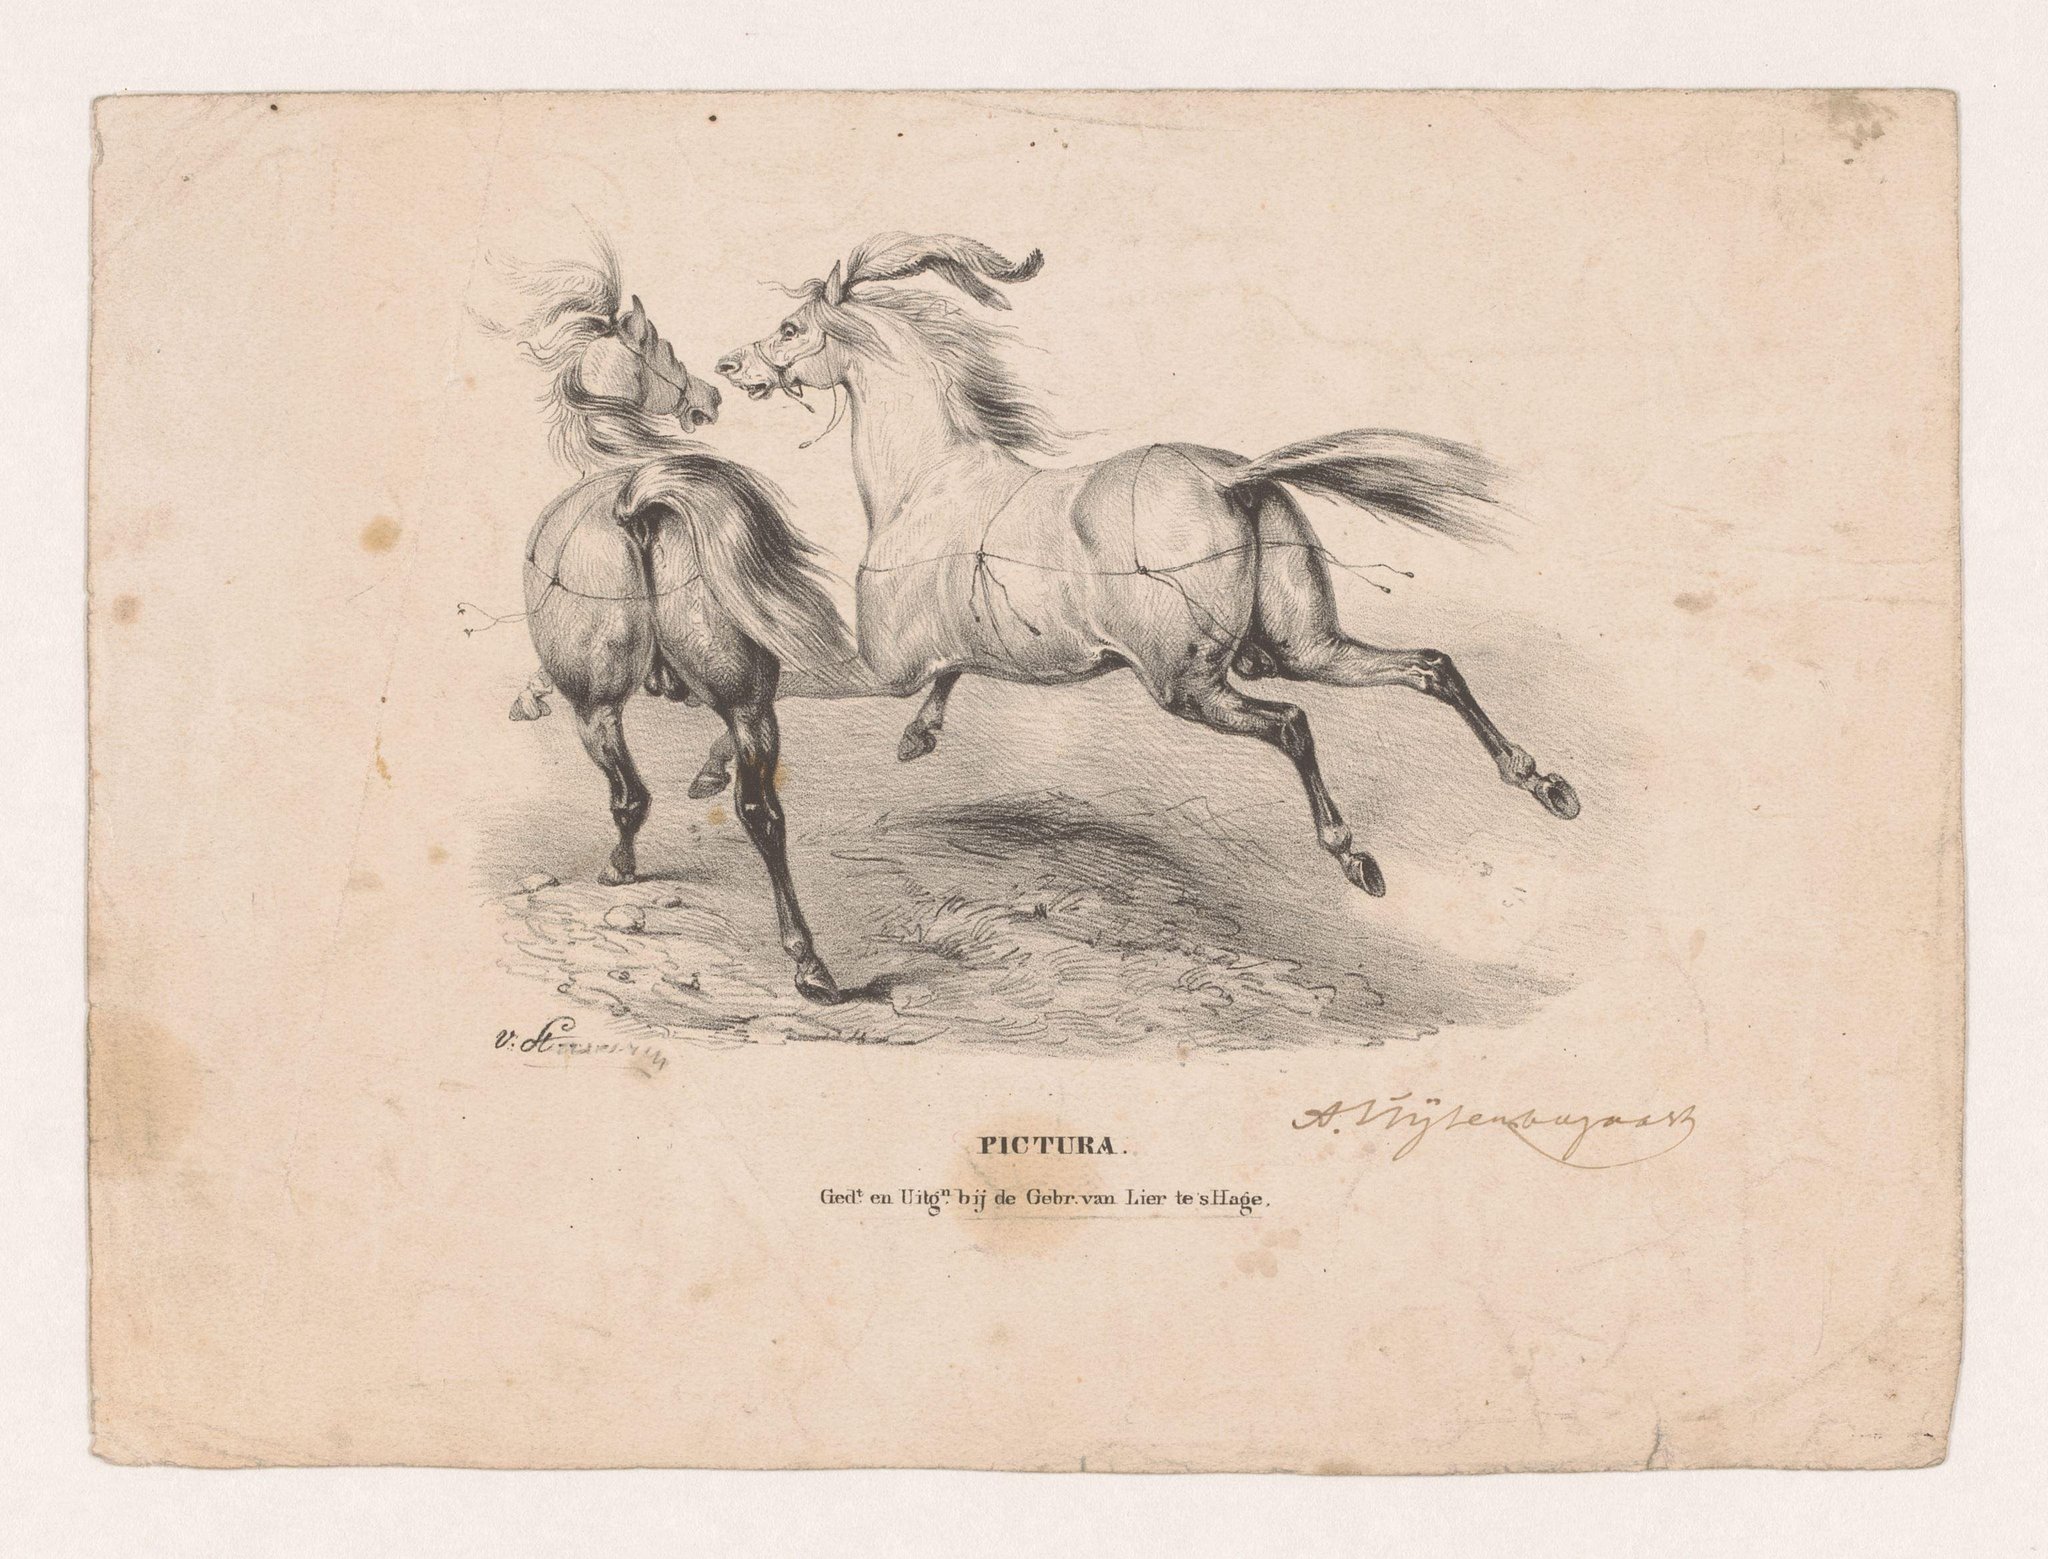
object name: print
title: Pictura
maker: gijsbert van staveren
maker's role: print maker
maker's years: 1790-1864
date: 1833-1850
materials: paper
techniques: lithograph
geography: the hague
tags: horse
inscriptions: inscription: ‘A. Uijtenbogaert’, collector's mark: Lugt 2228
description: Twee rennende paarden met veren op het hoofd, op de rug gezien.